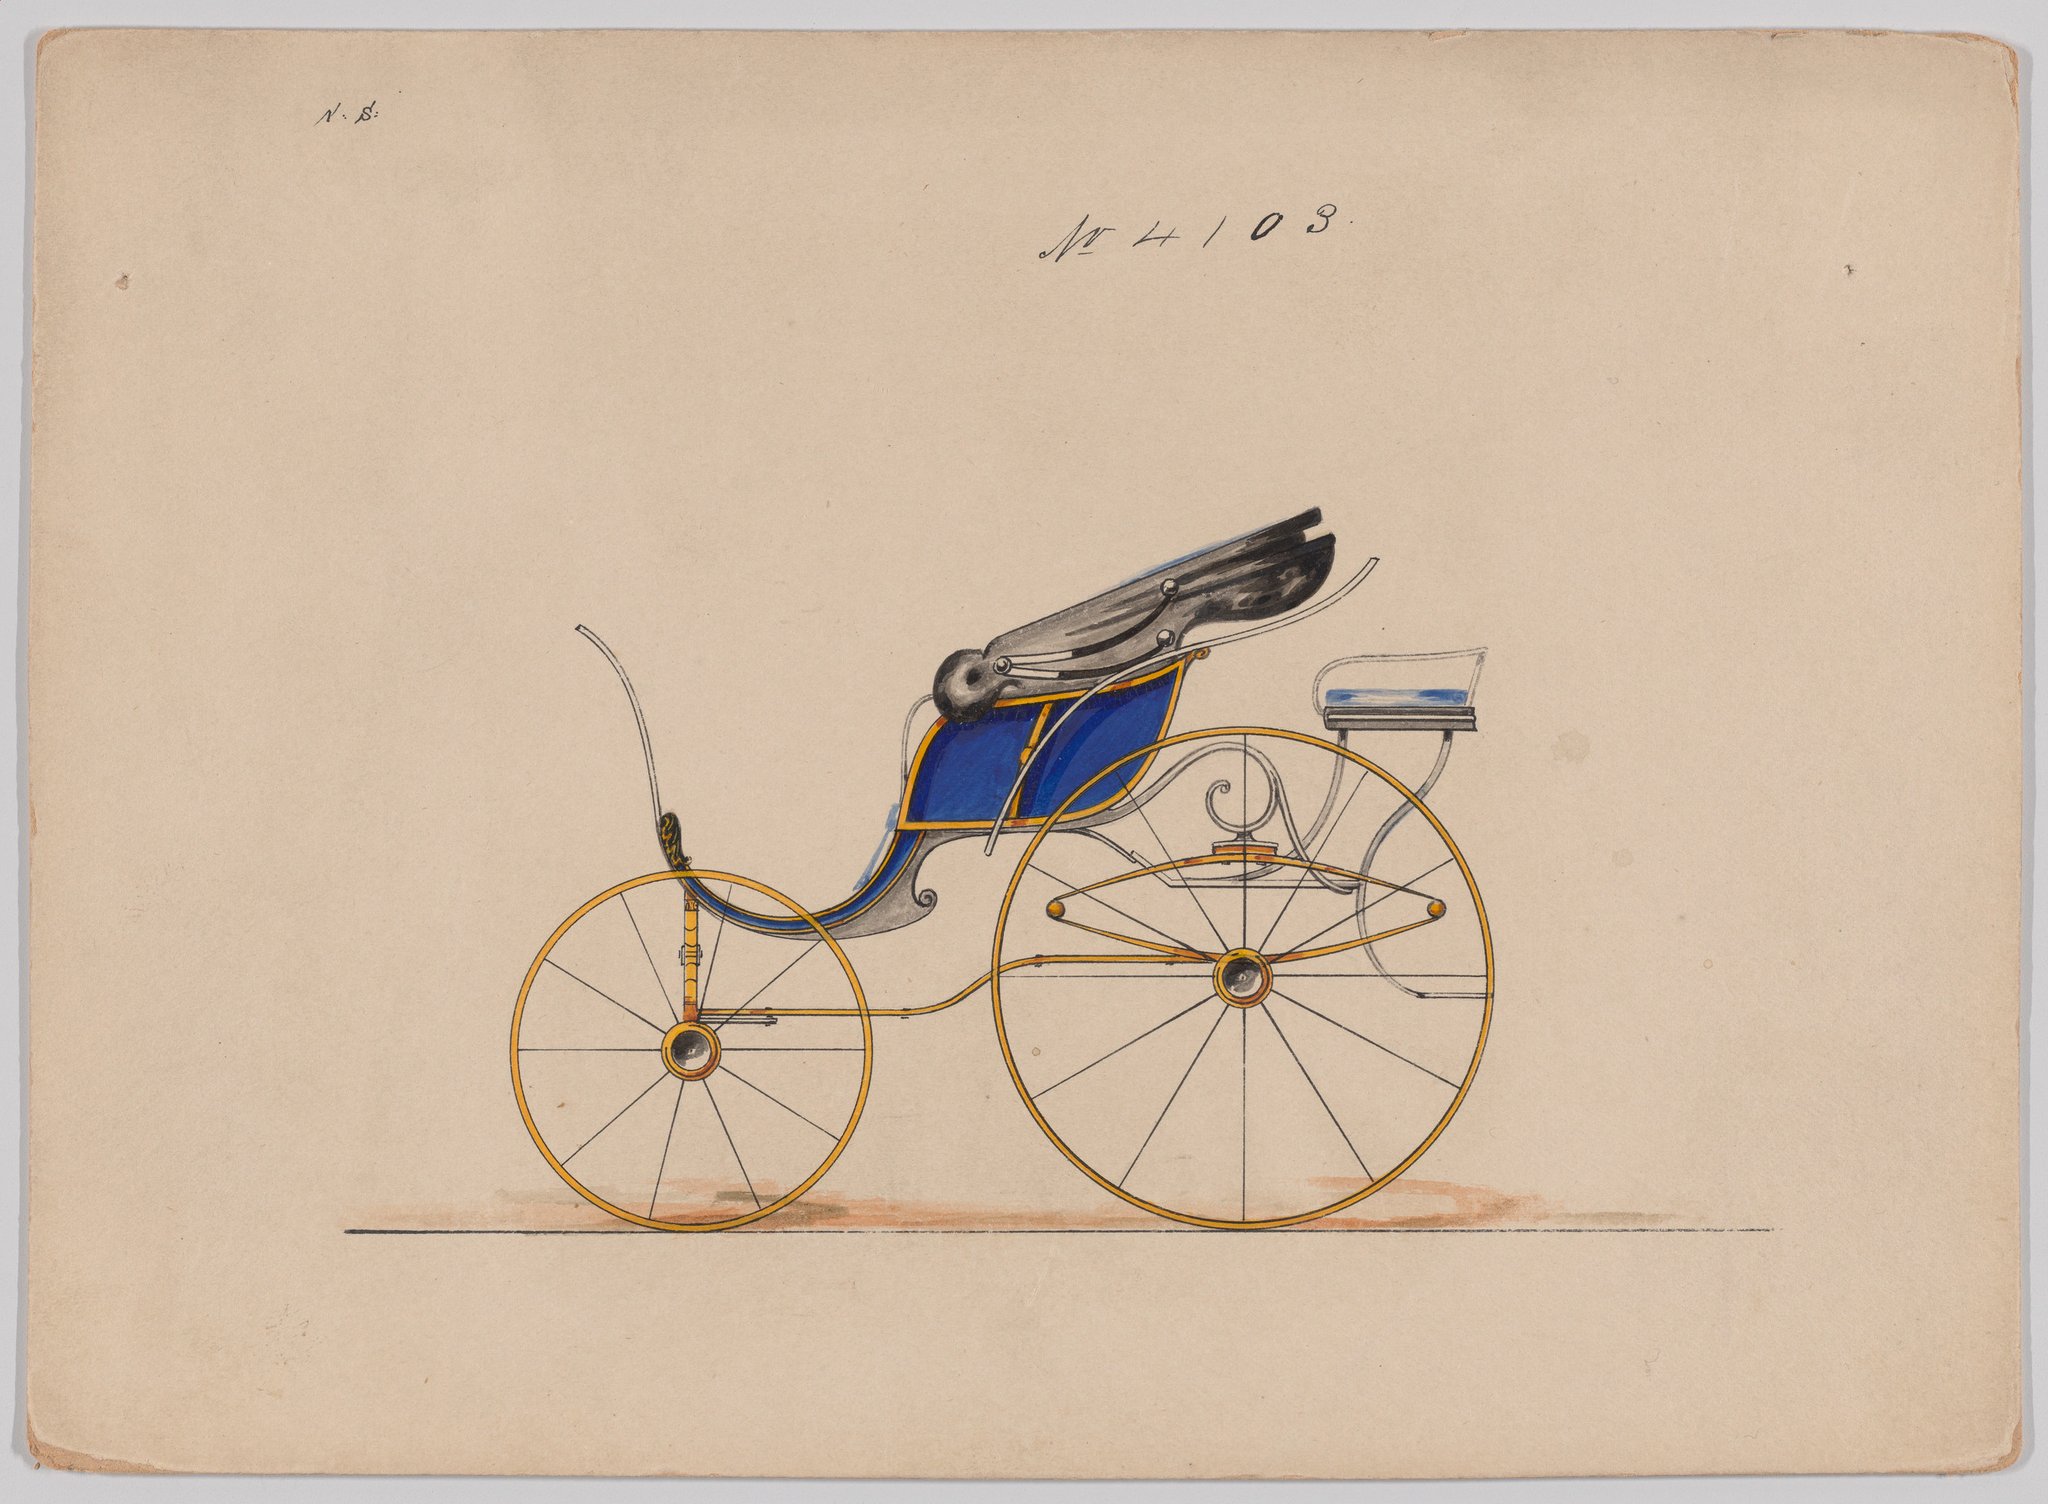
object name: drawing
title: Design for Pony Phaeton, no. 4103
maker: brewster & co.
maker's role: manufacturer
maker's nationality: american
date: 1890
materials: gouache, gum arabic, ink, watercolor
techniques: pen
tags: carriages